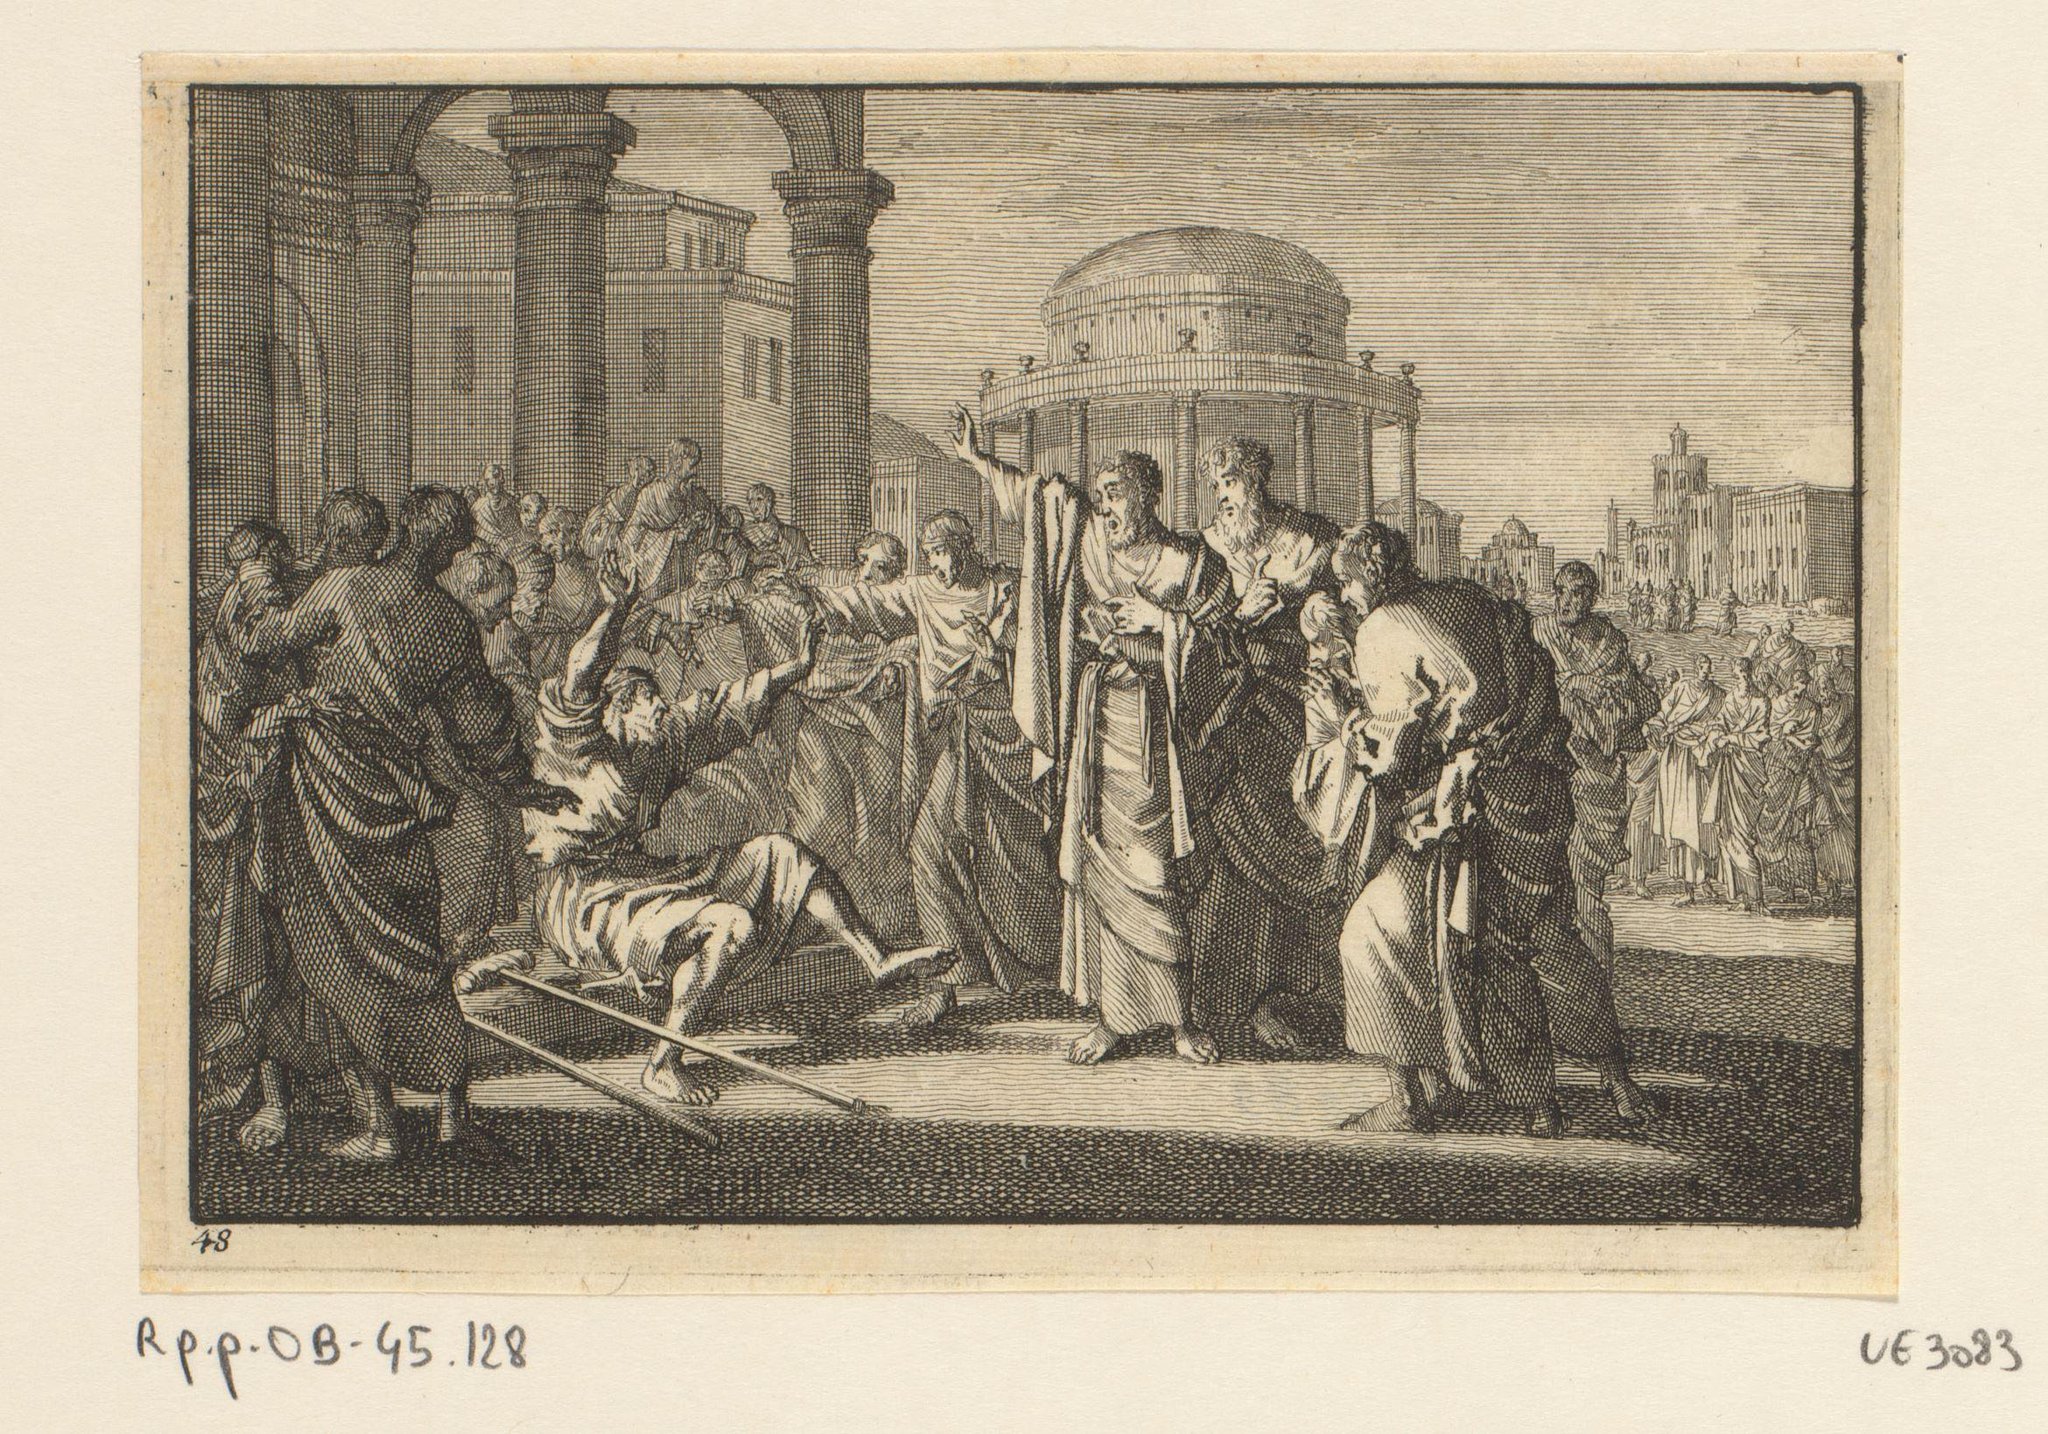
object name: print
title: Paulus geneest een kreupele te Lystra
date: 1703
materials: paper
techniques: etching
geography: amsterdam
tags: disabilities, deformations, paul and barnabas heal the feet of a man; the people of lystra think they are mercury and jupiter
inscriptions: collector's mark: Lugt 2228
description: Proefdruk van een boekillustratie voor David Martin. Historie des Ouden en Nieuwen Testaments. Amsterdam, Pieter Mortier, 1703. Deel II. De boekillustraties voor de Mortierbijbel hebben verschillende staten en kopieën, waarbij de chronologische volgorde moeilijk te achterhalen valt. Als boekillustraties werden ze bovendien herhaaldelijk opnieuw gebruikt voor andere boekwerken.